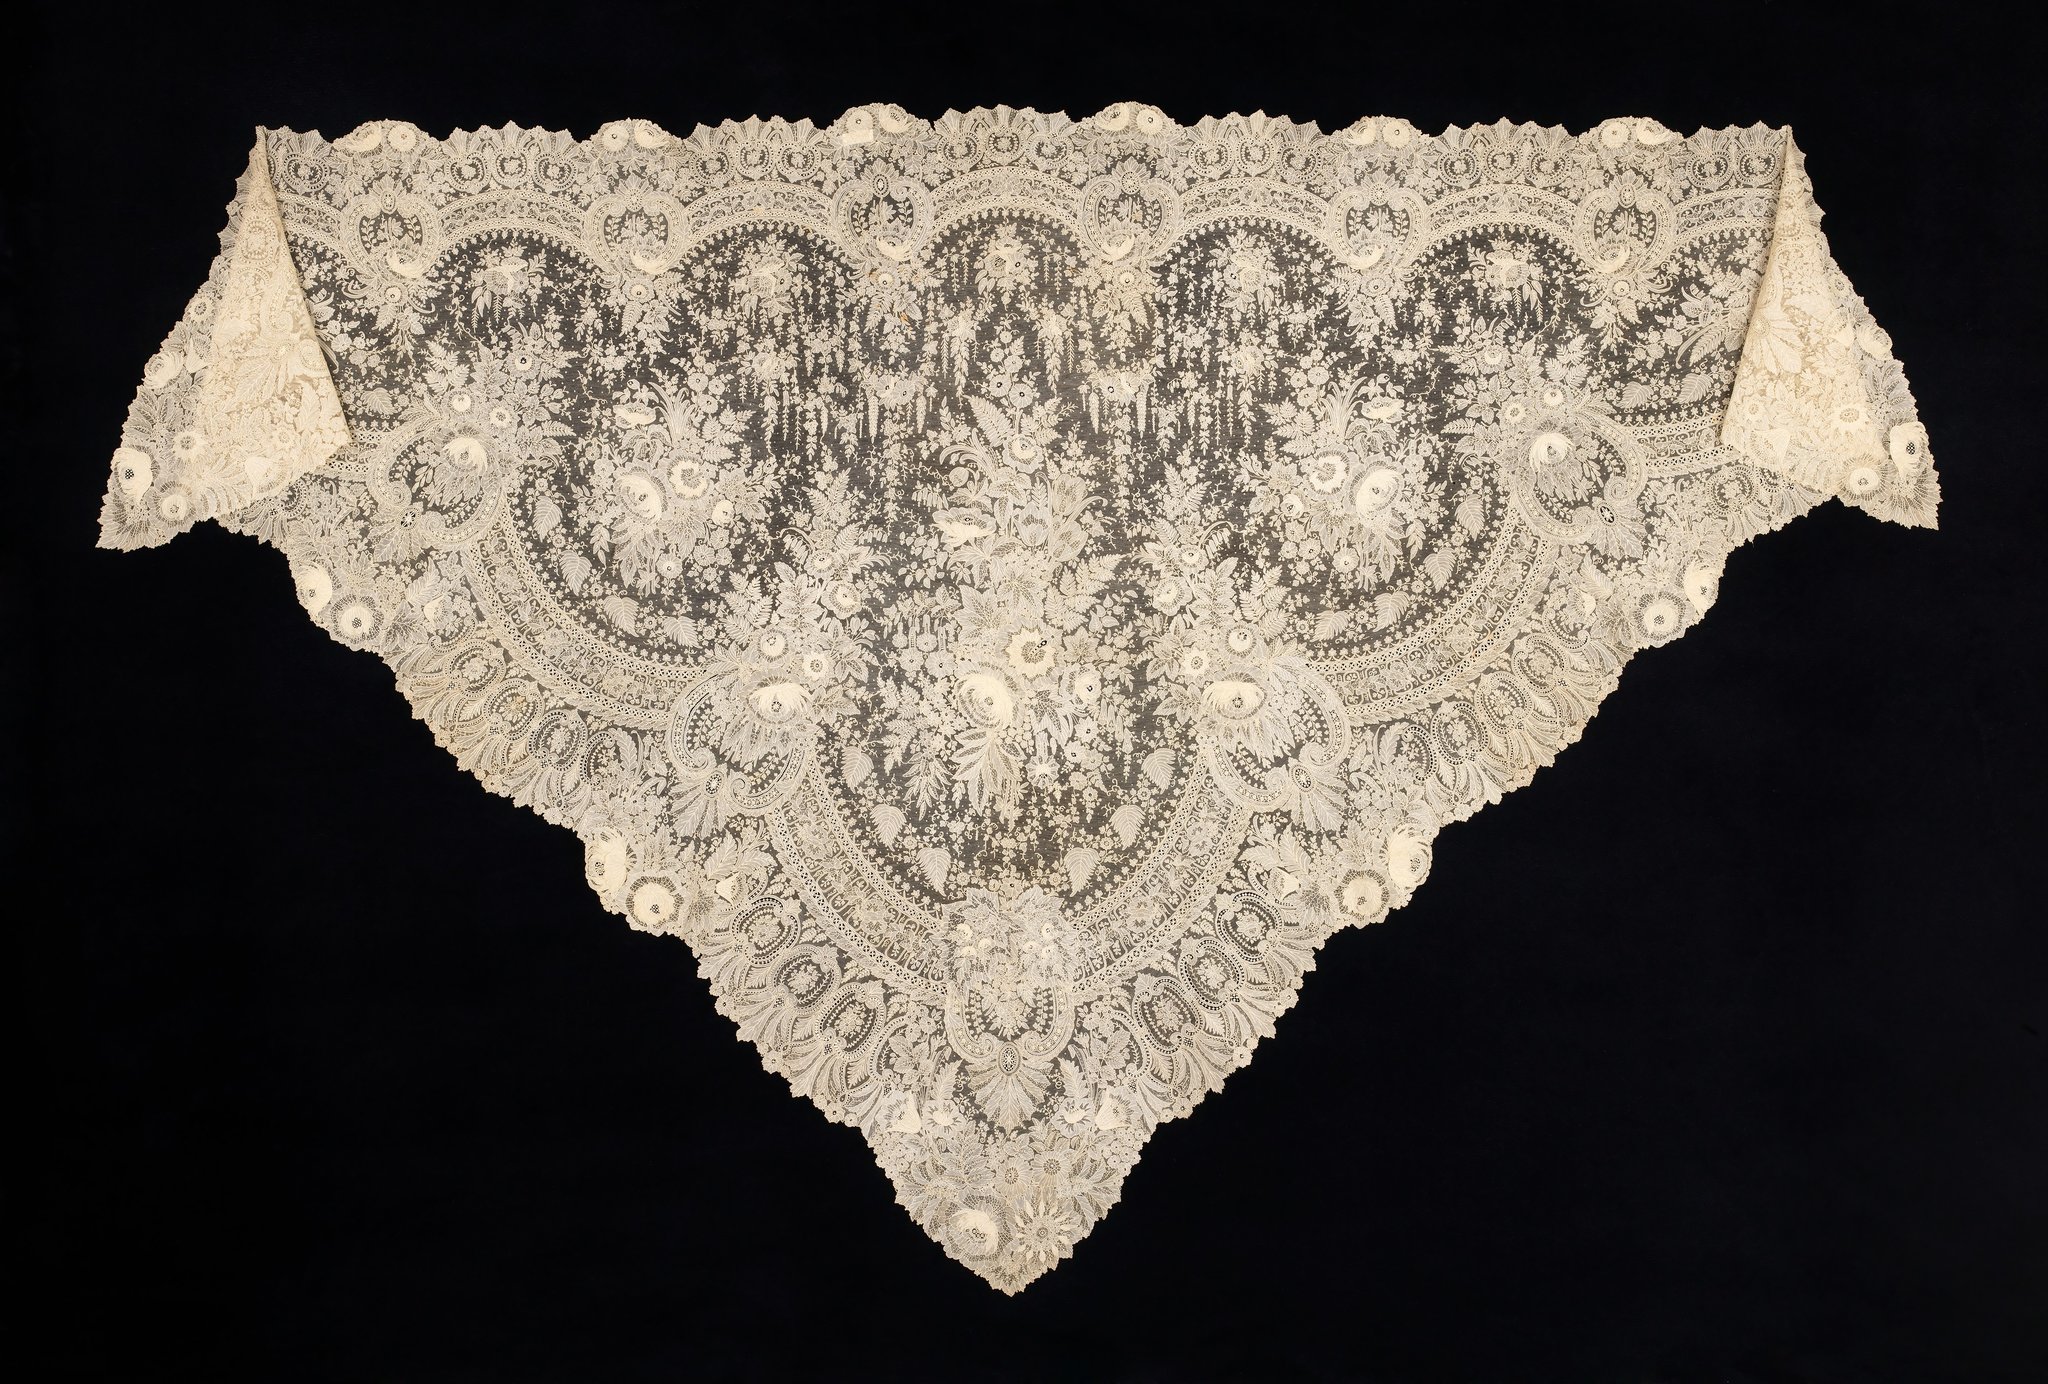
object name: shawl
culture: belgian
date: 1860-1870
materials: linen